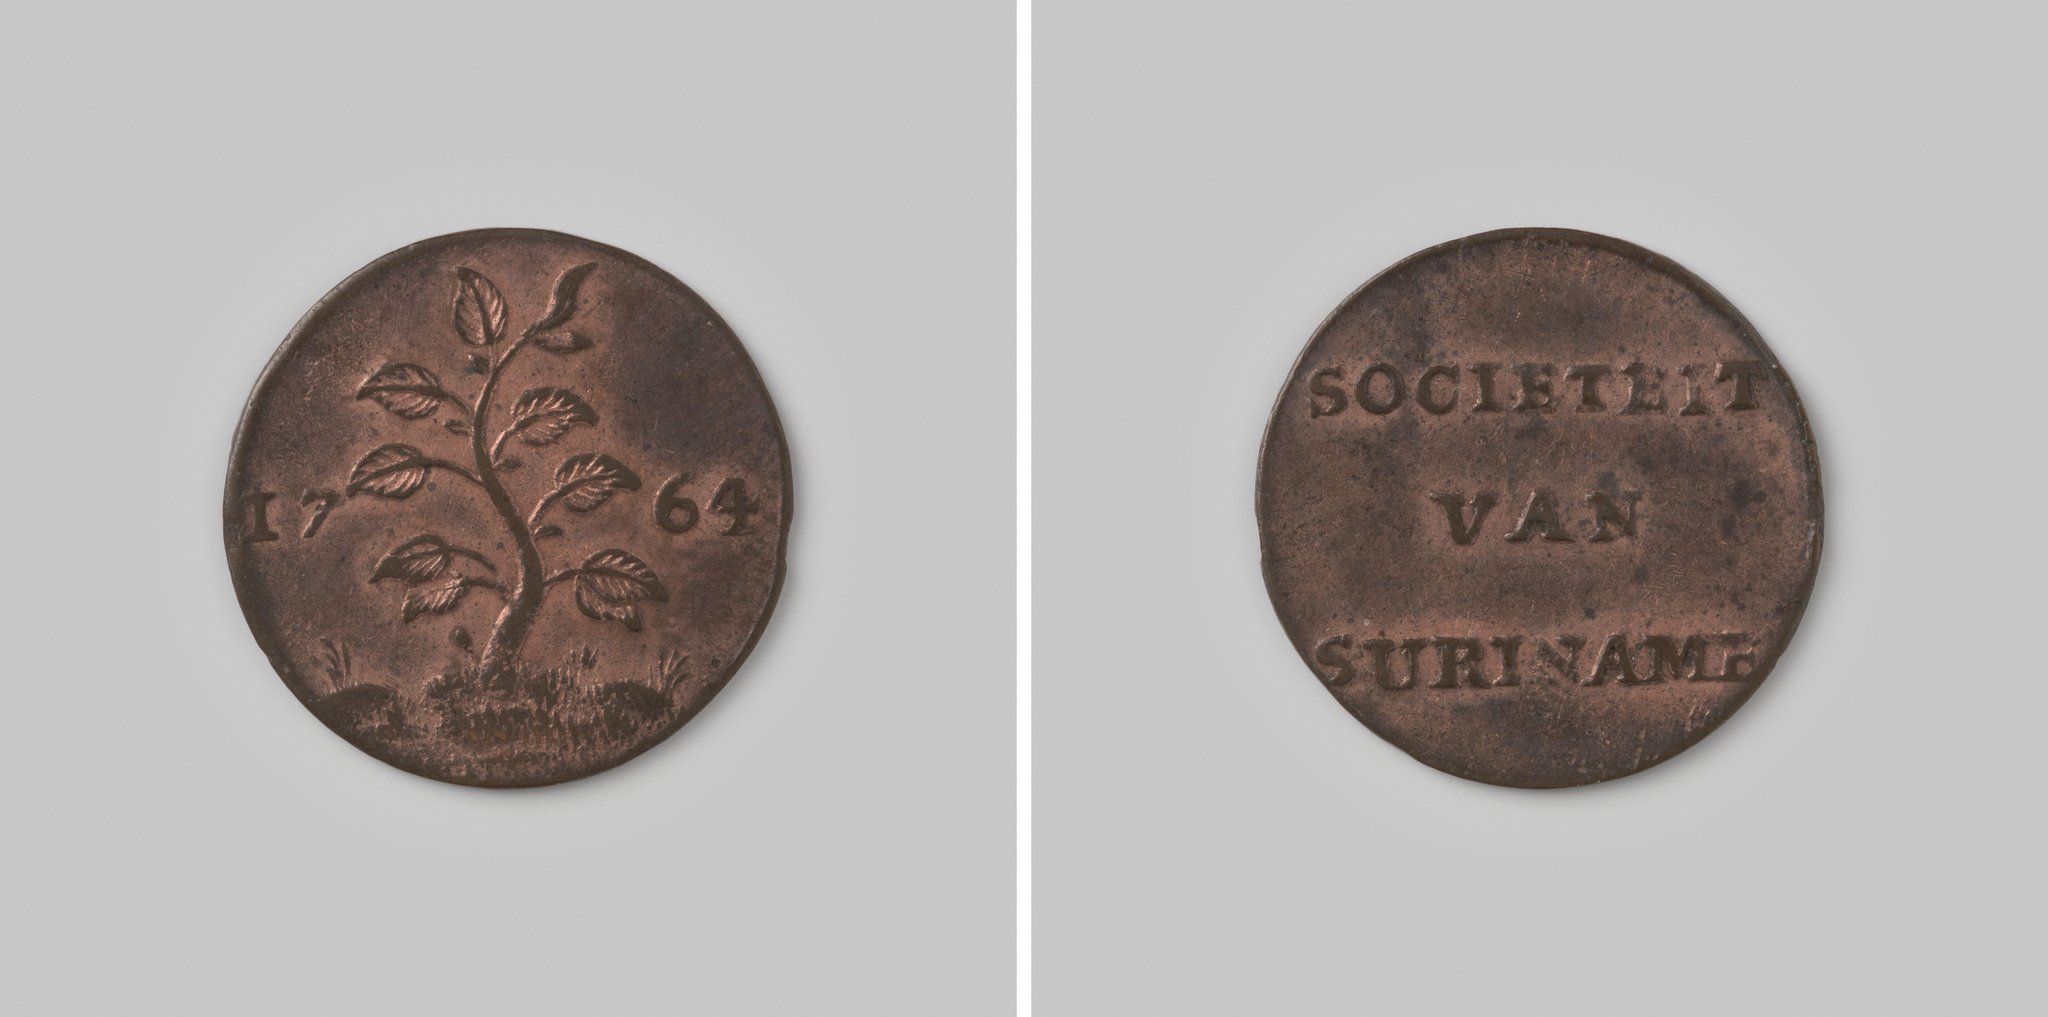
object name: coin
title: Suriname, duit, 1764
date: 1764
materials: copper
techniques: striking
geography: enkhuizen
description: Koperen munt. Voorzijde: tussen jaartal een op grond staande cacaoboom. Keerzijde: in drie regels lands-aanduiding: SOCIETEIT VAN SURINAME.